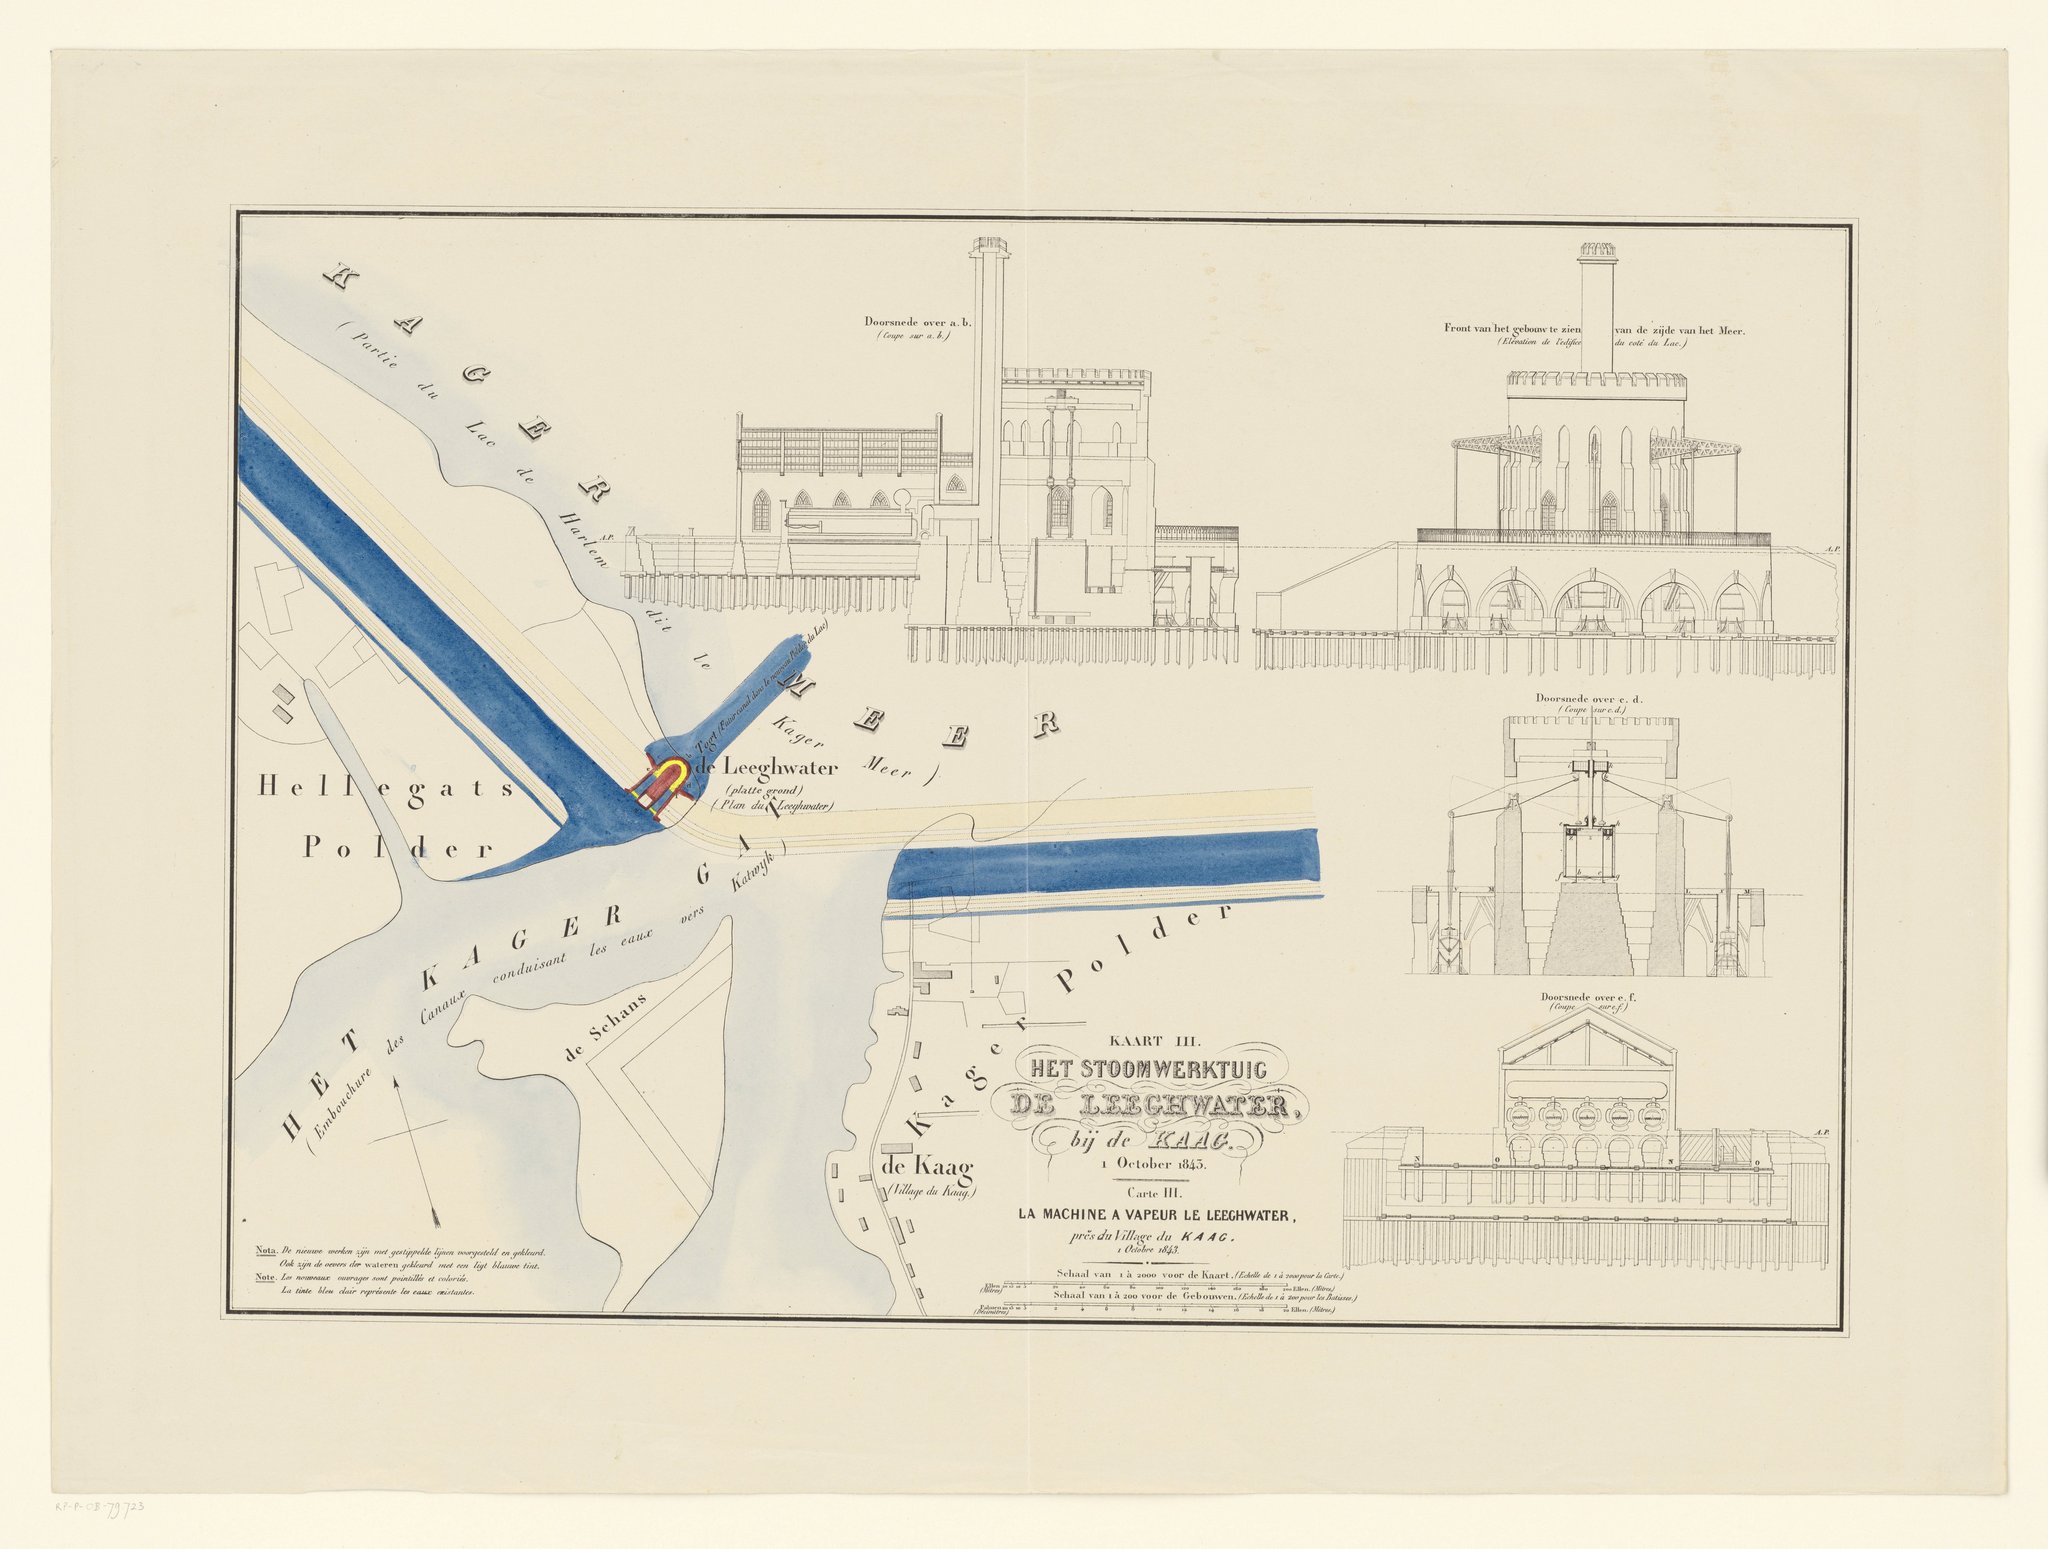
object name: print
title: Suite van tien kaarten en platen van de droogmaking van de Haarlemmermeer 1843-1860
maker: Anonymous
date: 1843-1861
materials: paper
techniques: hand coloring, lithograph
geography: netherlands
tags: maps of separate countries or regions, technical aspects and details of pumping-engine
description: Kaart met de ligging van het stoomgemaal De Leeghwater bij de Kaag, 1 oktober 1843. Rechts drie doorsneden en een aanzicht van het stoomgemaal. Opschriften in het Nederlands en Frans. Onderdeel van een suite van tien platen van de droogmaking van de Haarlemmermeer, 1843-1860.